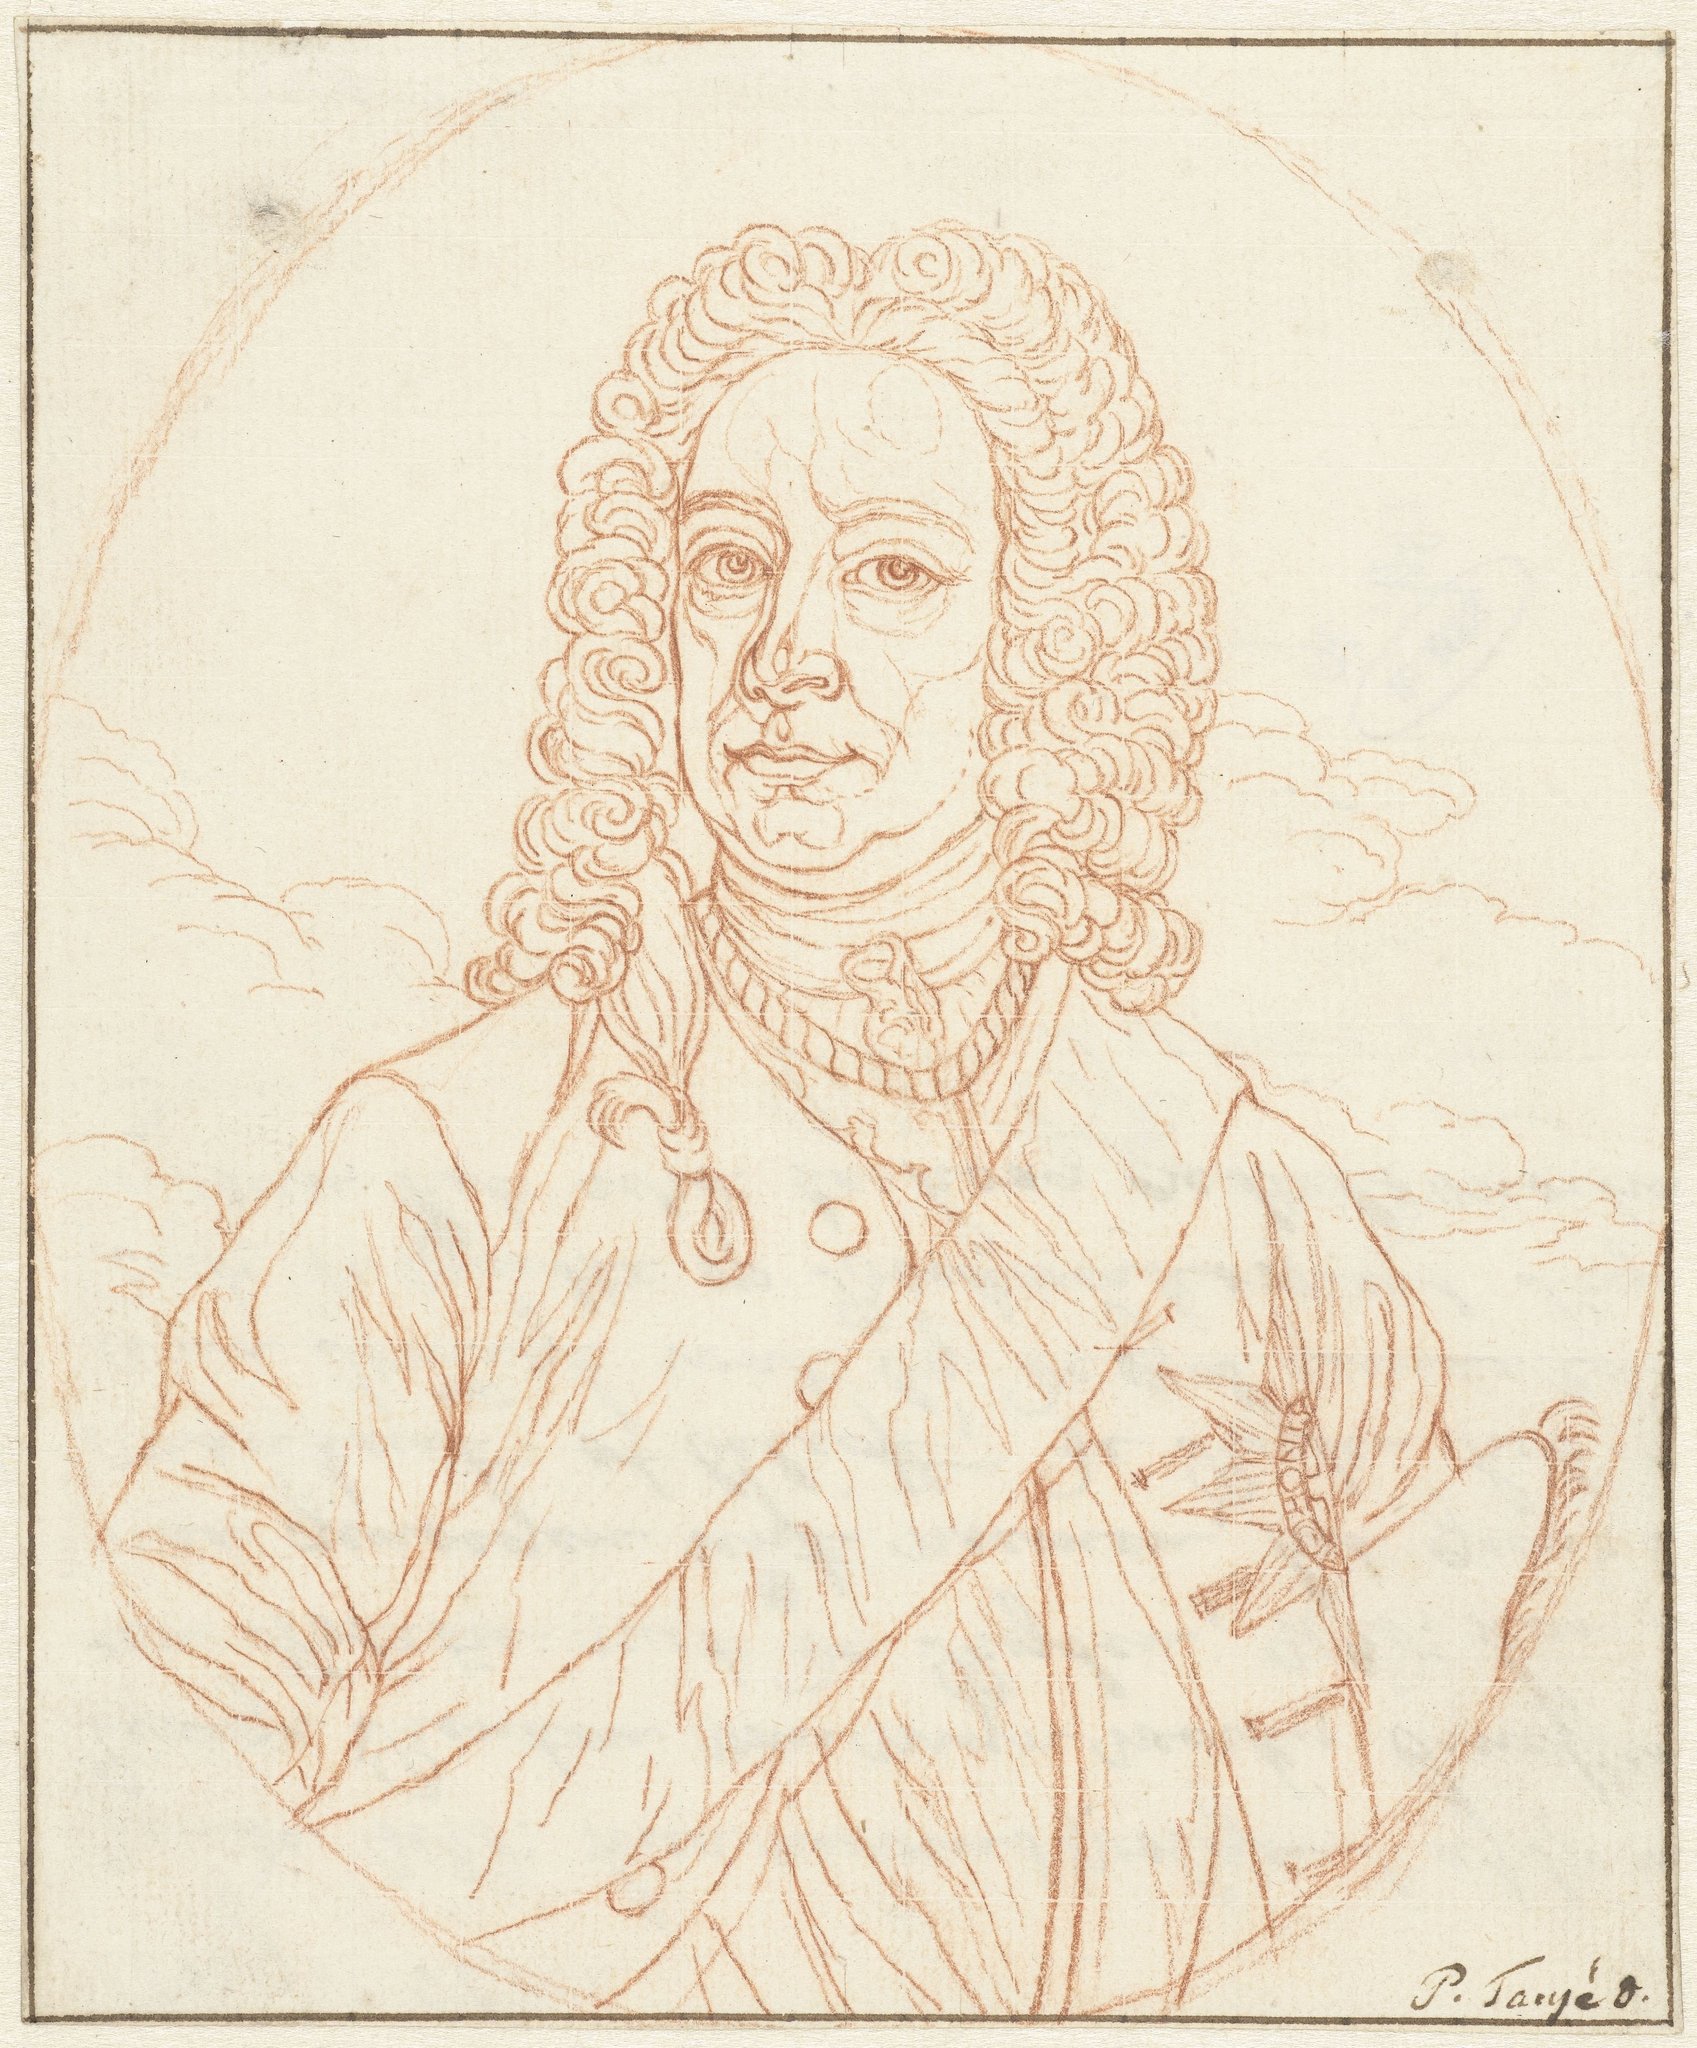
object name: design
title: Portret van George II Augustus, koning van Engeland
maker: pieter tanjé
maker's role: draughtsman, print maker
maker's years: 1706-1761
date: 1741-1761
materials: ink, paper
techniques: pen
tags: london, george ii augustus (koning van groot-brittannië), historical persons, king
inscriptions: inscription: ‘Mijn Heer / zende Ued: hier neevens (volgens afspraa/ Eenige Prenten van mijn werk, beneffen/ een Notitie met de Prysen, Ued: kan z/ naa genoegen uyt neemen, het geene U/ mankeert of belieft, de Prysen heb ik/ van sommige wat by de gis gemaakt/ doch de meeste op Boekverkoopers Prys/ indien het ued: te hoog gesteld mocht/ zyn / Udw Pieter Tanje’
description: Portret van George II Augustus (1683-1765), koning van Engeland. Verso: (concept van) een brief van Tanjé. Ontwerp voor een prent.